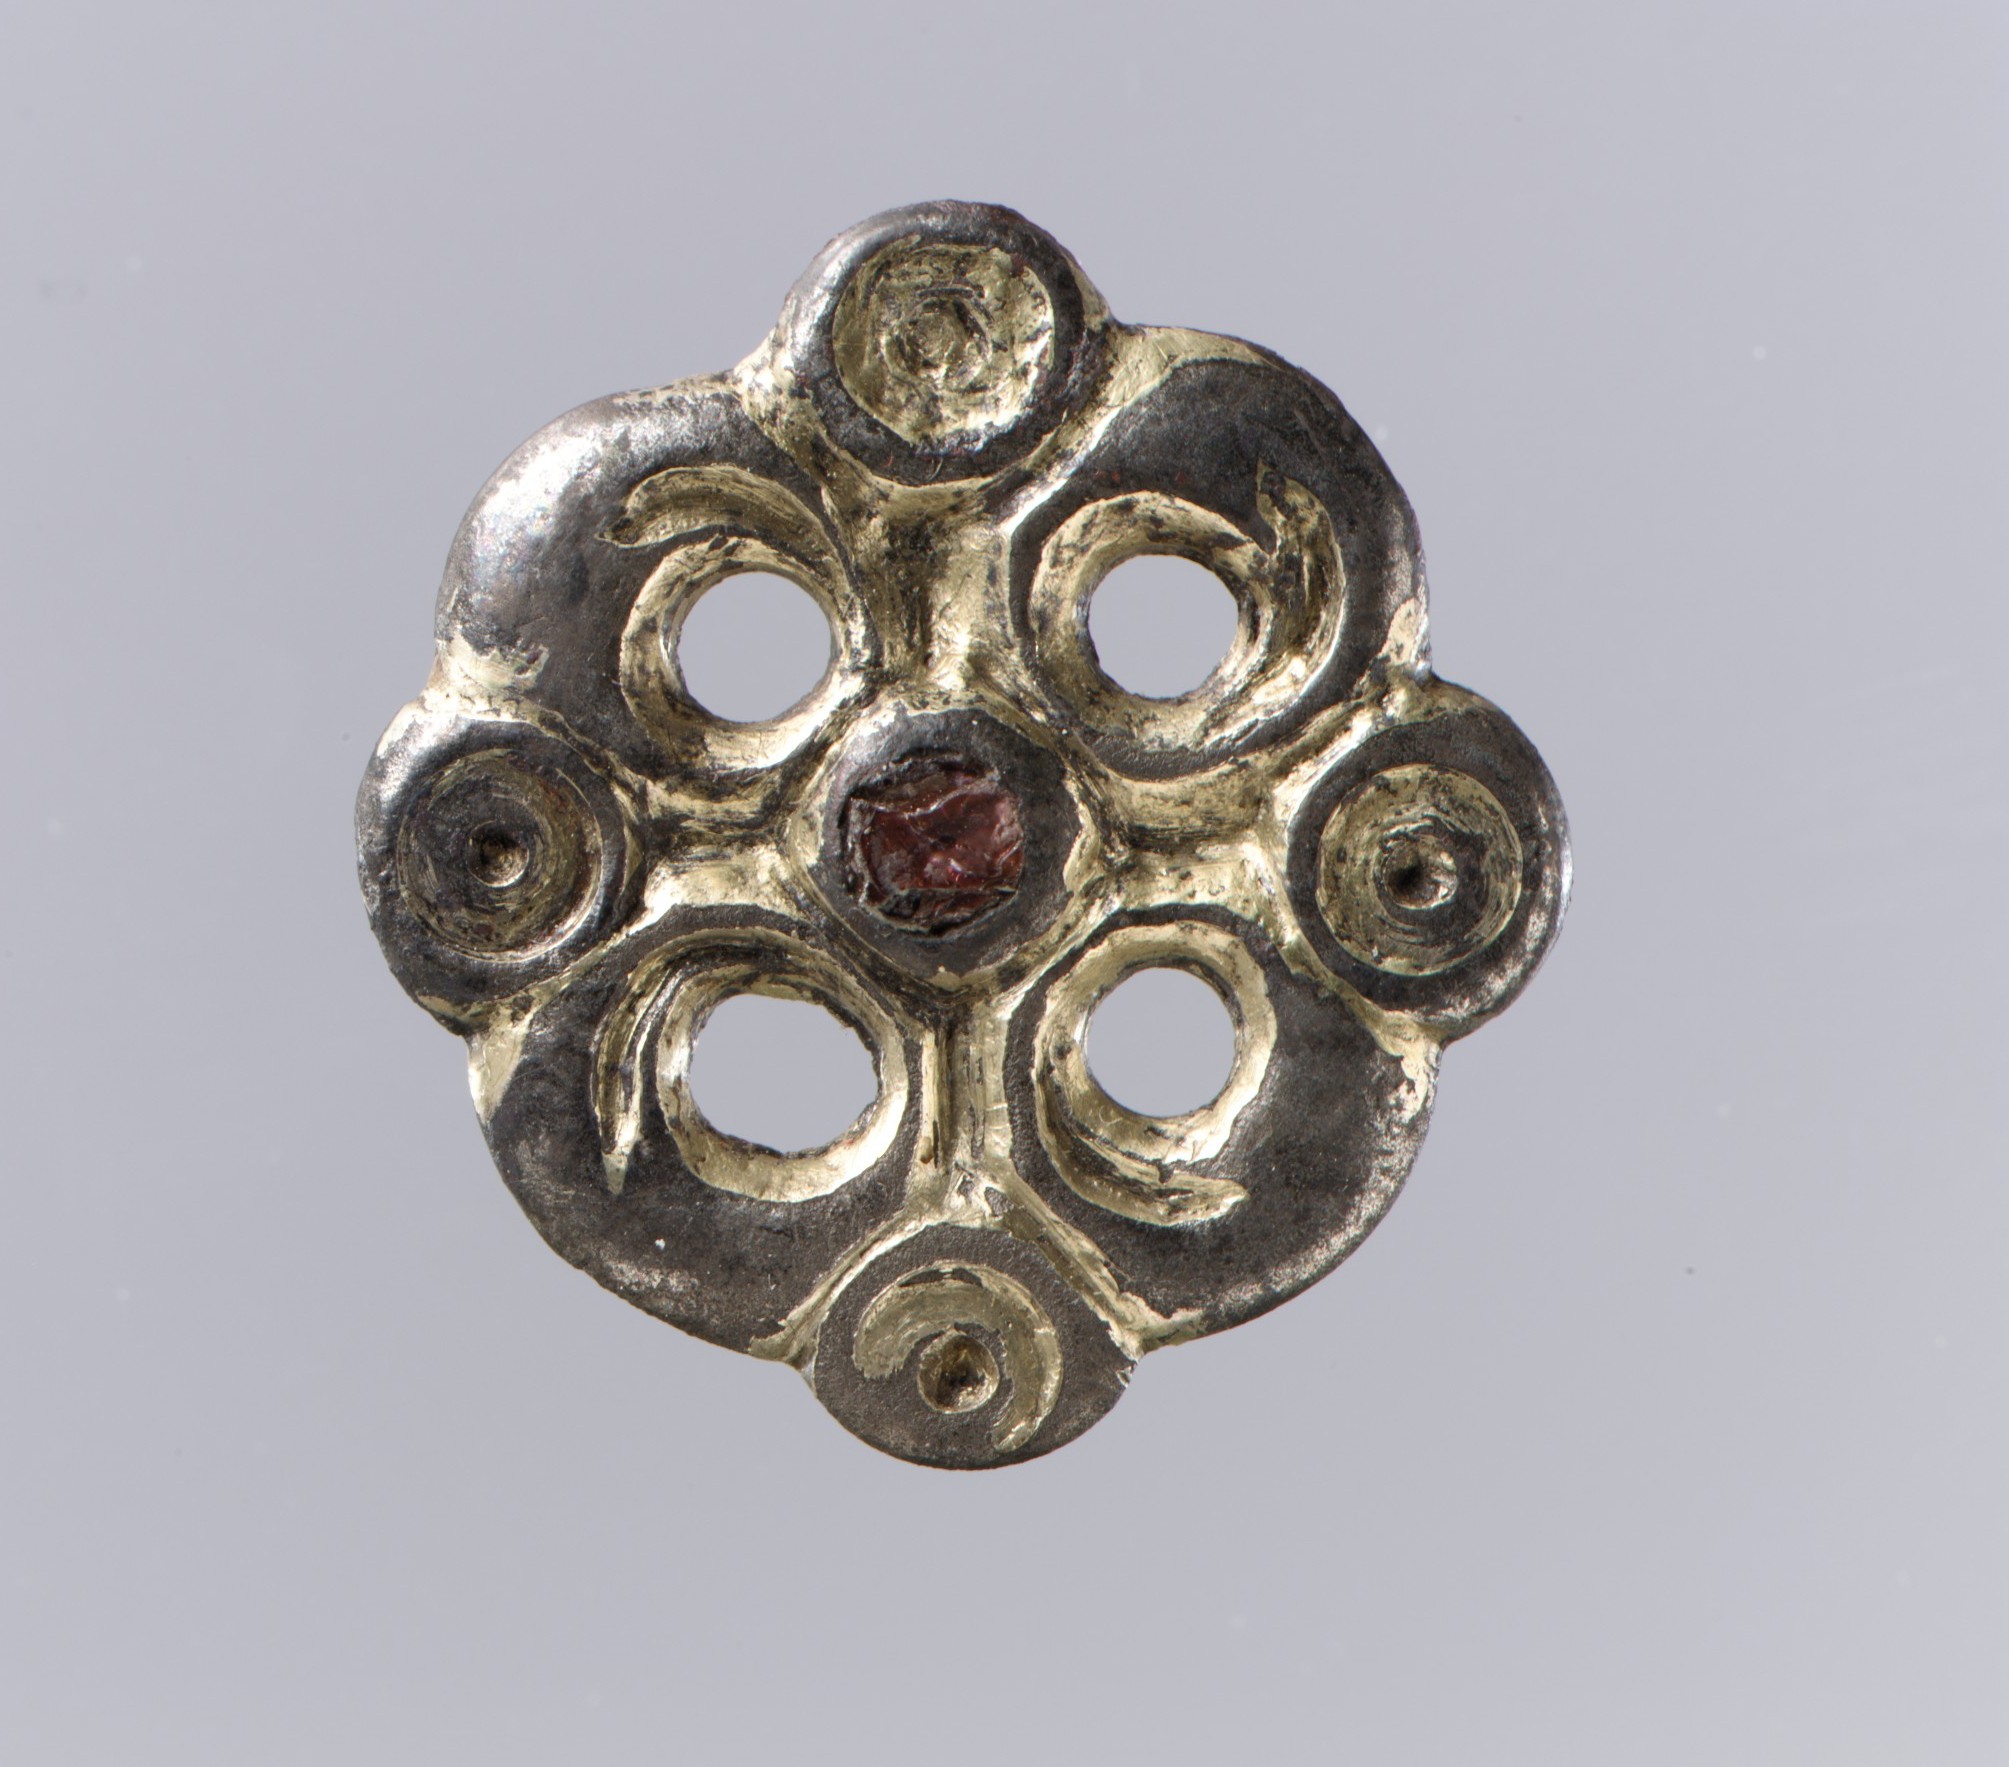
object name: brooch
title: Openwork Rosette Brooch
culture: frankish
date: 501-600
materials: gemstone, iron, silver, silver gilt